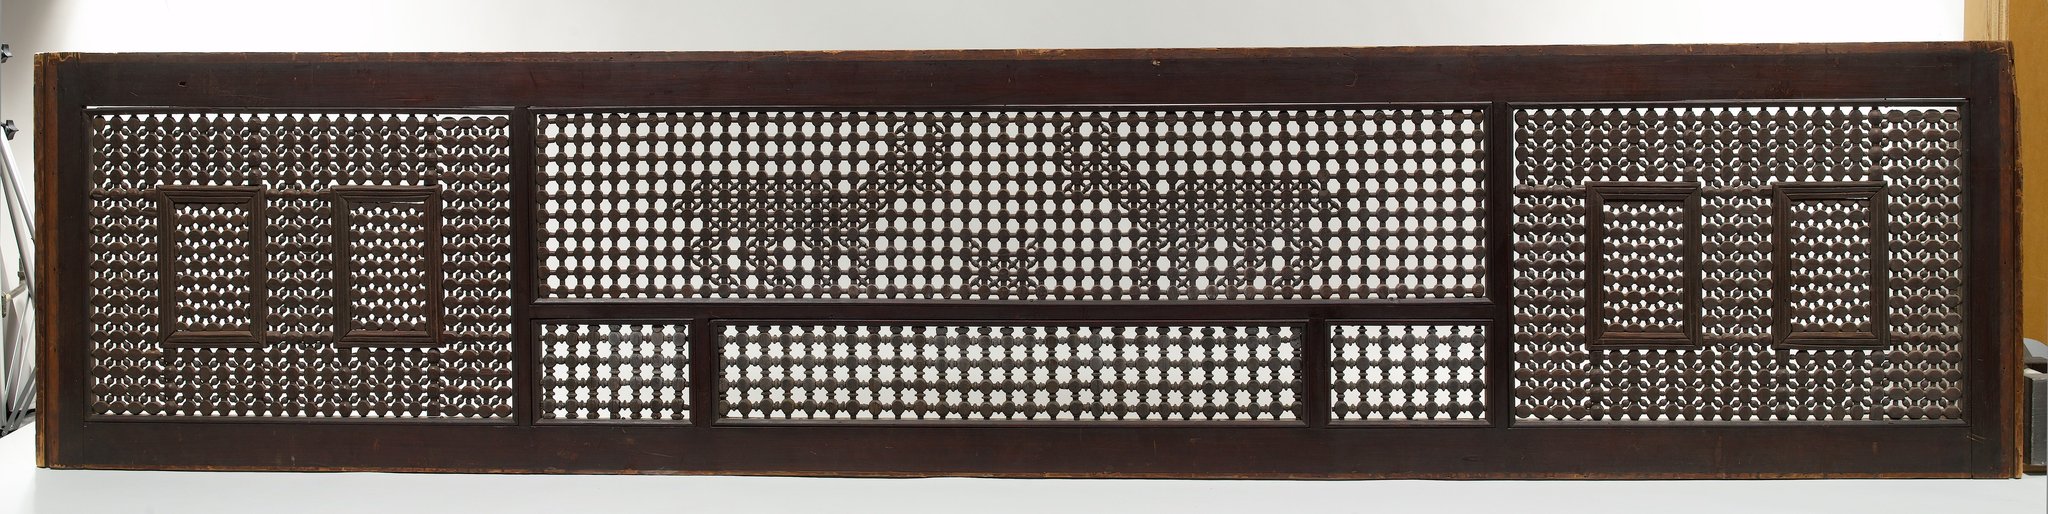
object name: screen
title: Mashrabiyya Screen with Two Gazelles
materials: wood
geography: egypt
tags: animals,screens